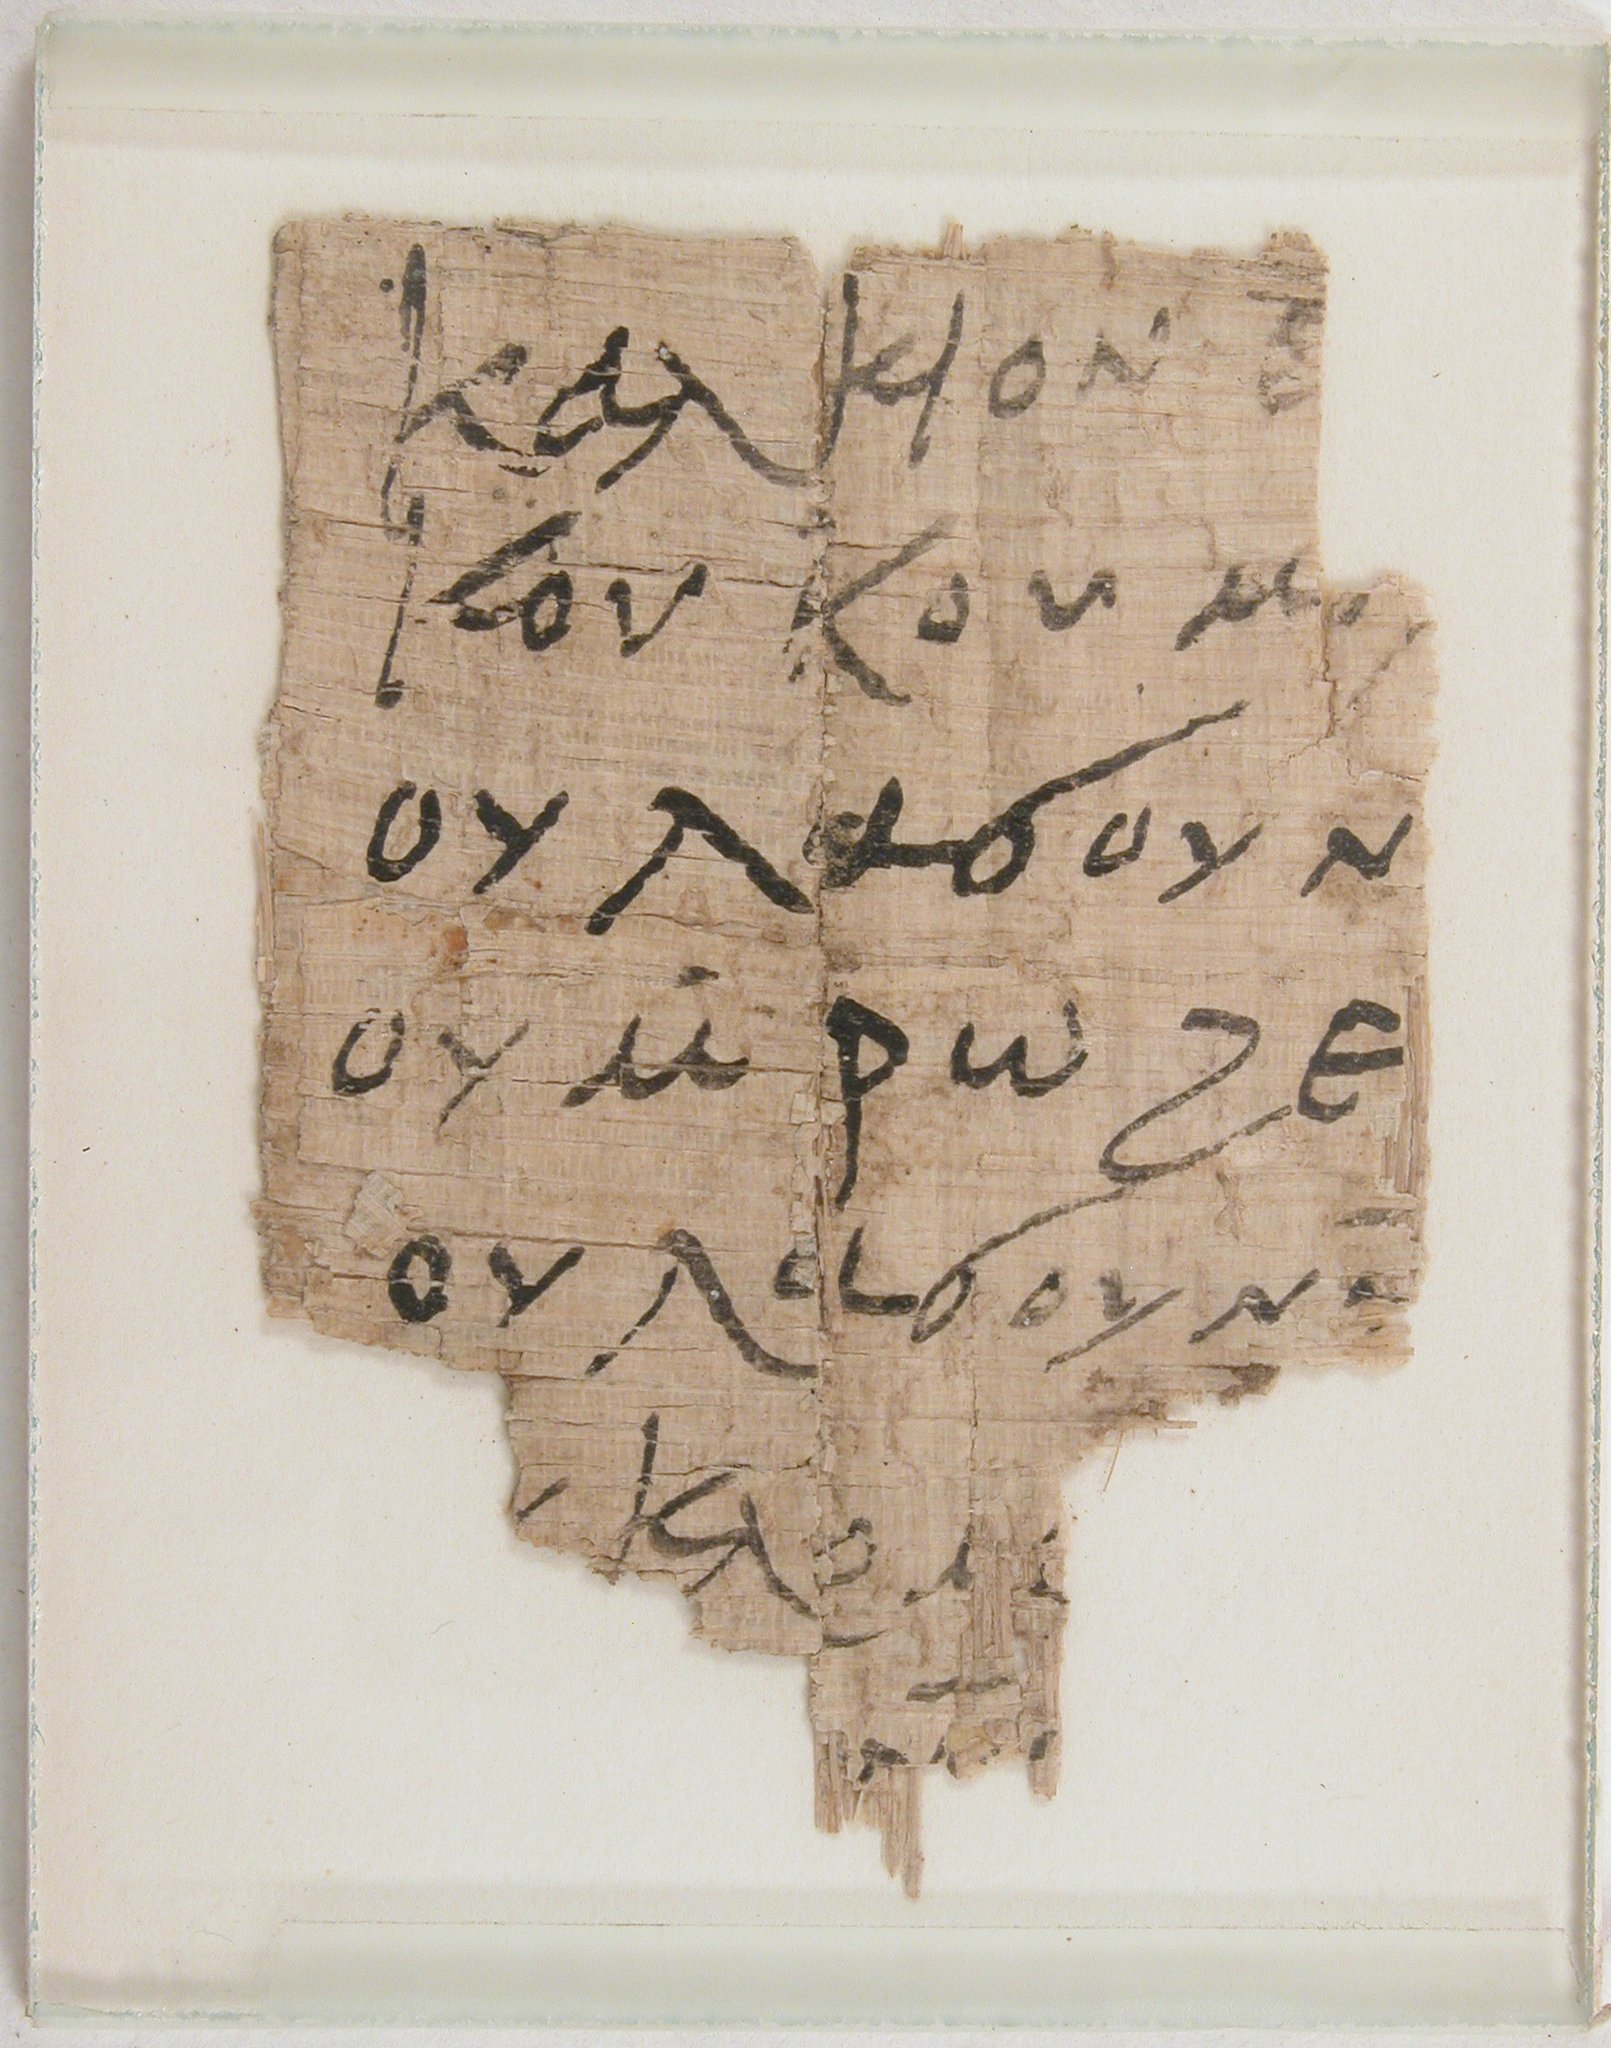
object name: fragment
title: Papyrus Fragment of a List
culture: coptic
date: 601-700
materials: ink, papyrus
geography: egypt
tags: coptic,documents